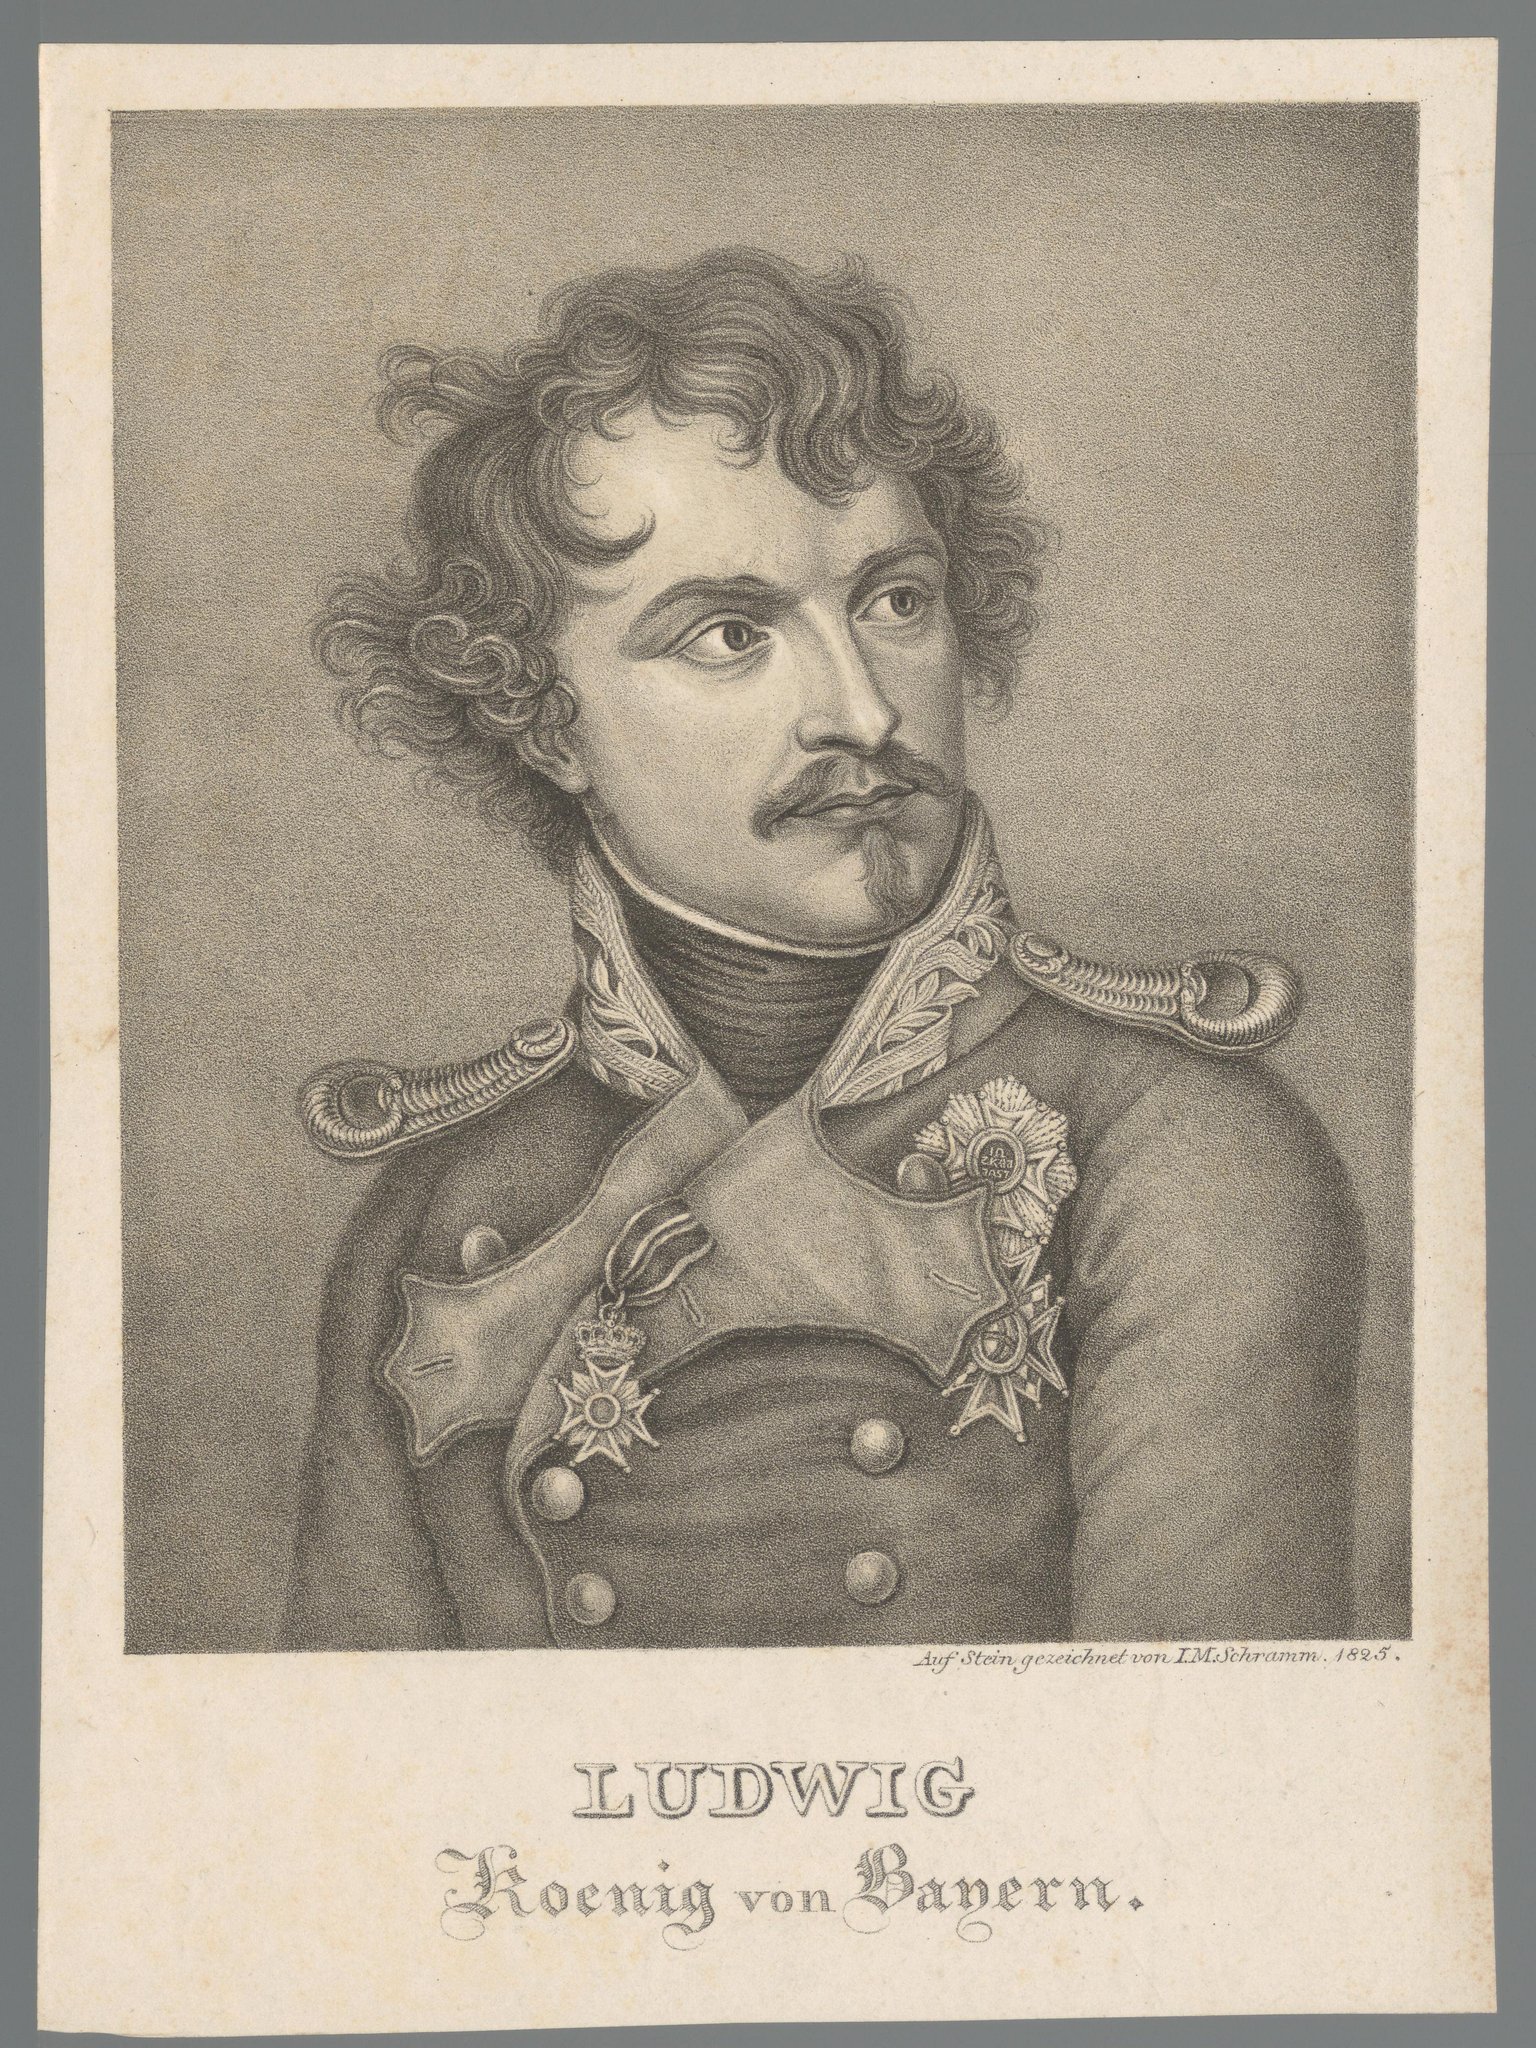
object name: print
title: Portret van Lodewijk I van Beieren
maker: johann michael schramm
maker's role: artist, print maker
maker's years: 1772-1835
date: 1825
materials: paper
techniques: lithograph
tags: lodewijk i (koning van beieren), historical persons, king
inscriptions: collector's mark: Lugt 2228